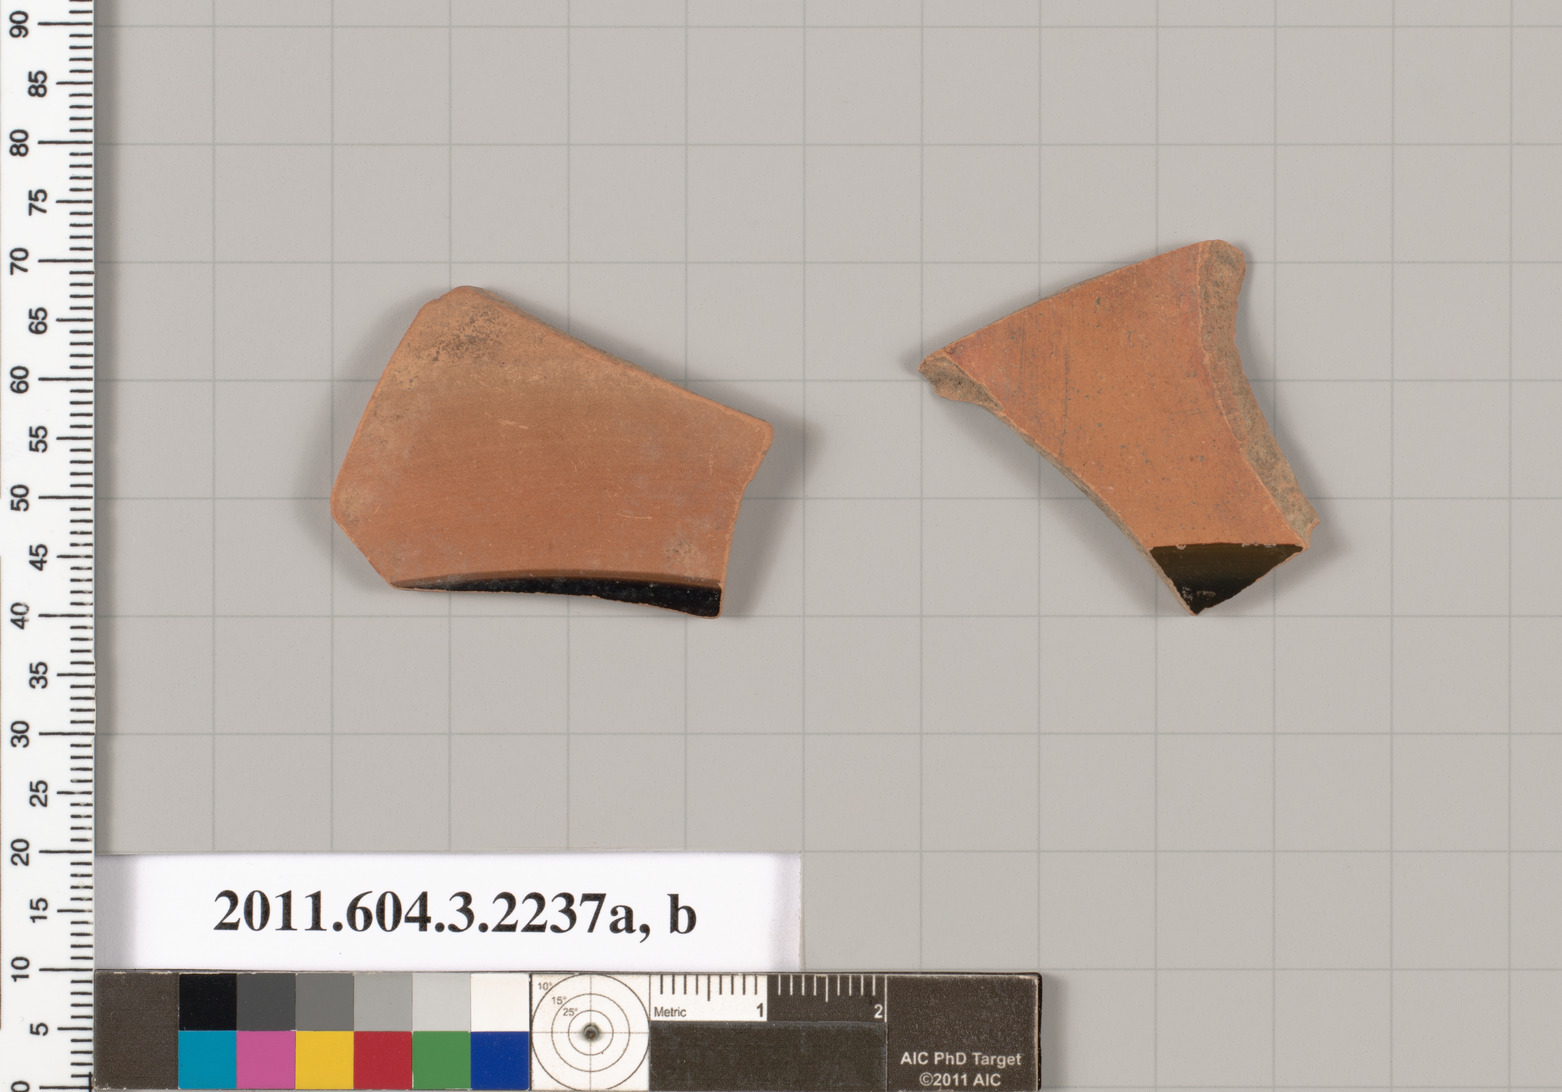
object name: kylix fragment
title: Terracotta fragments of kylikes (drinking cups)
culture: greek, attic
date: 600-401 BCE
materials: terracotta